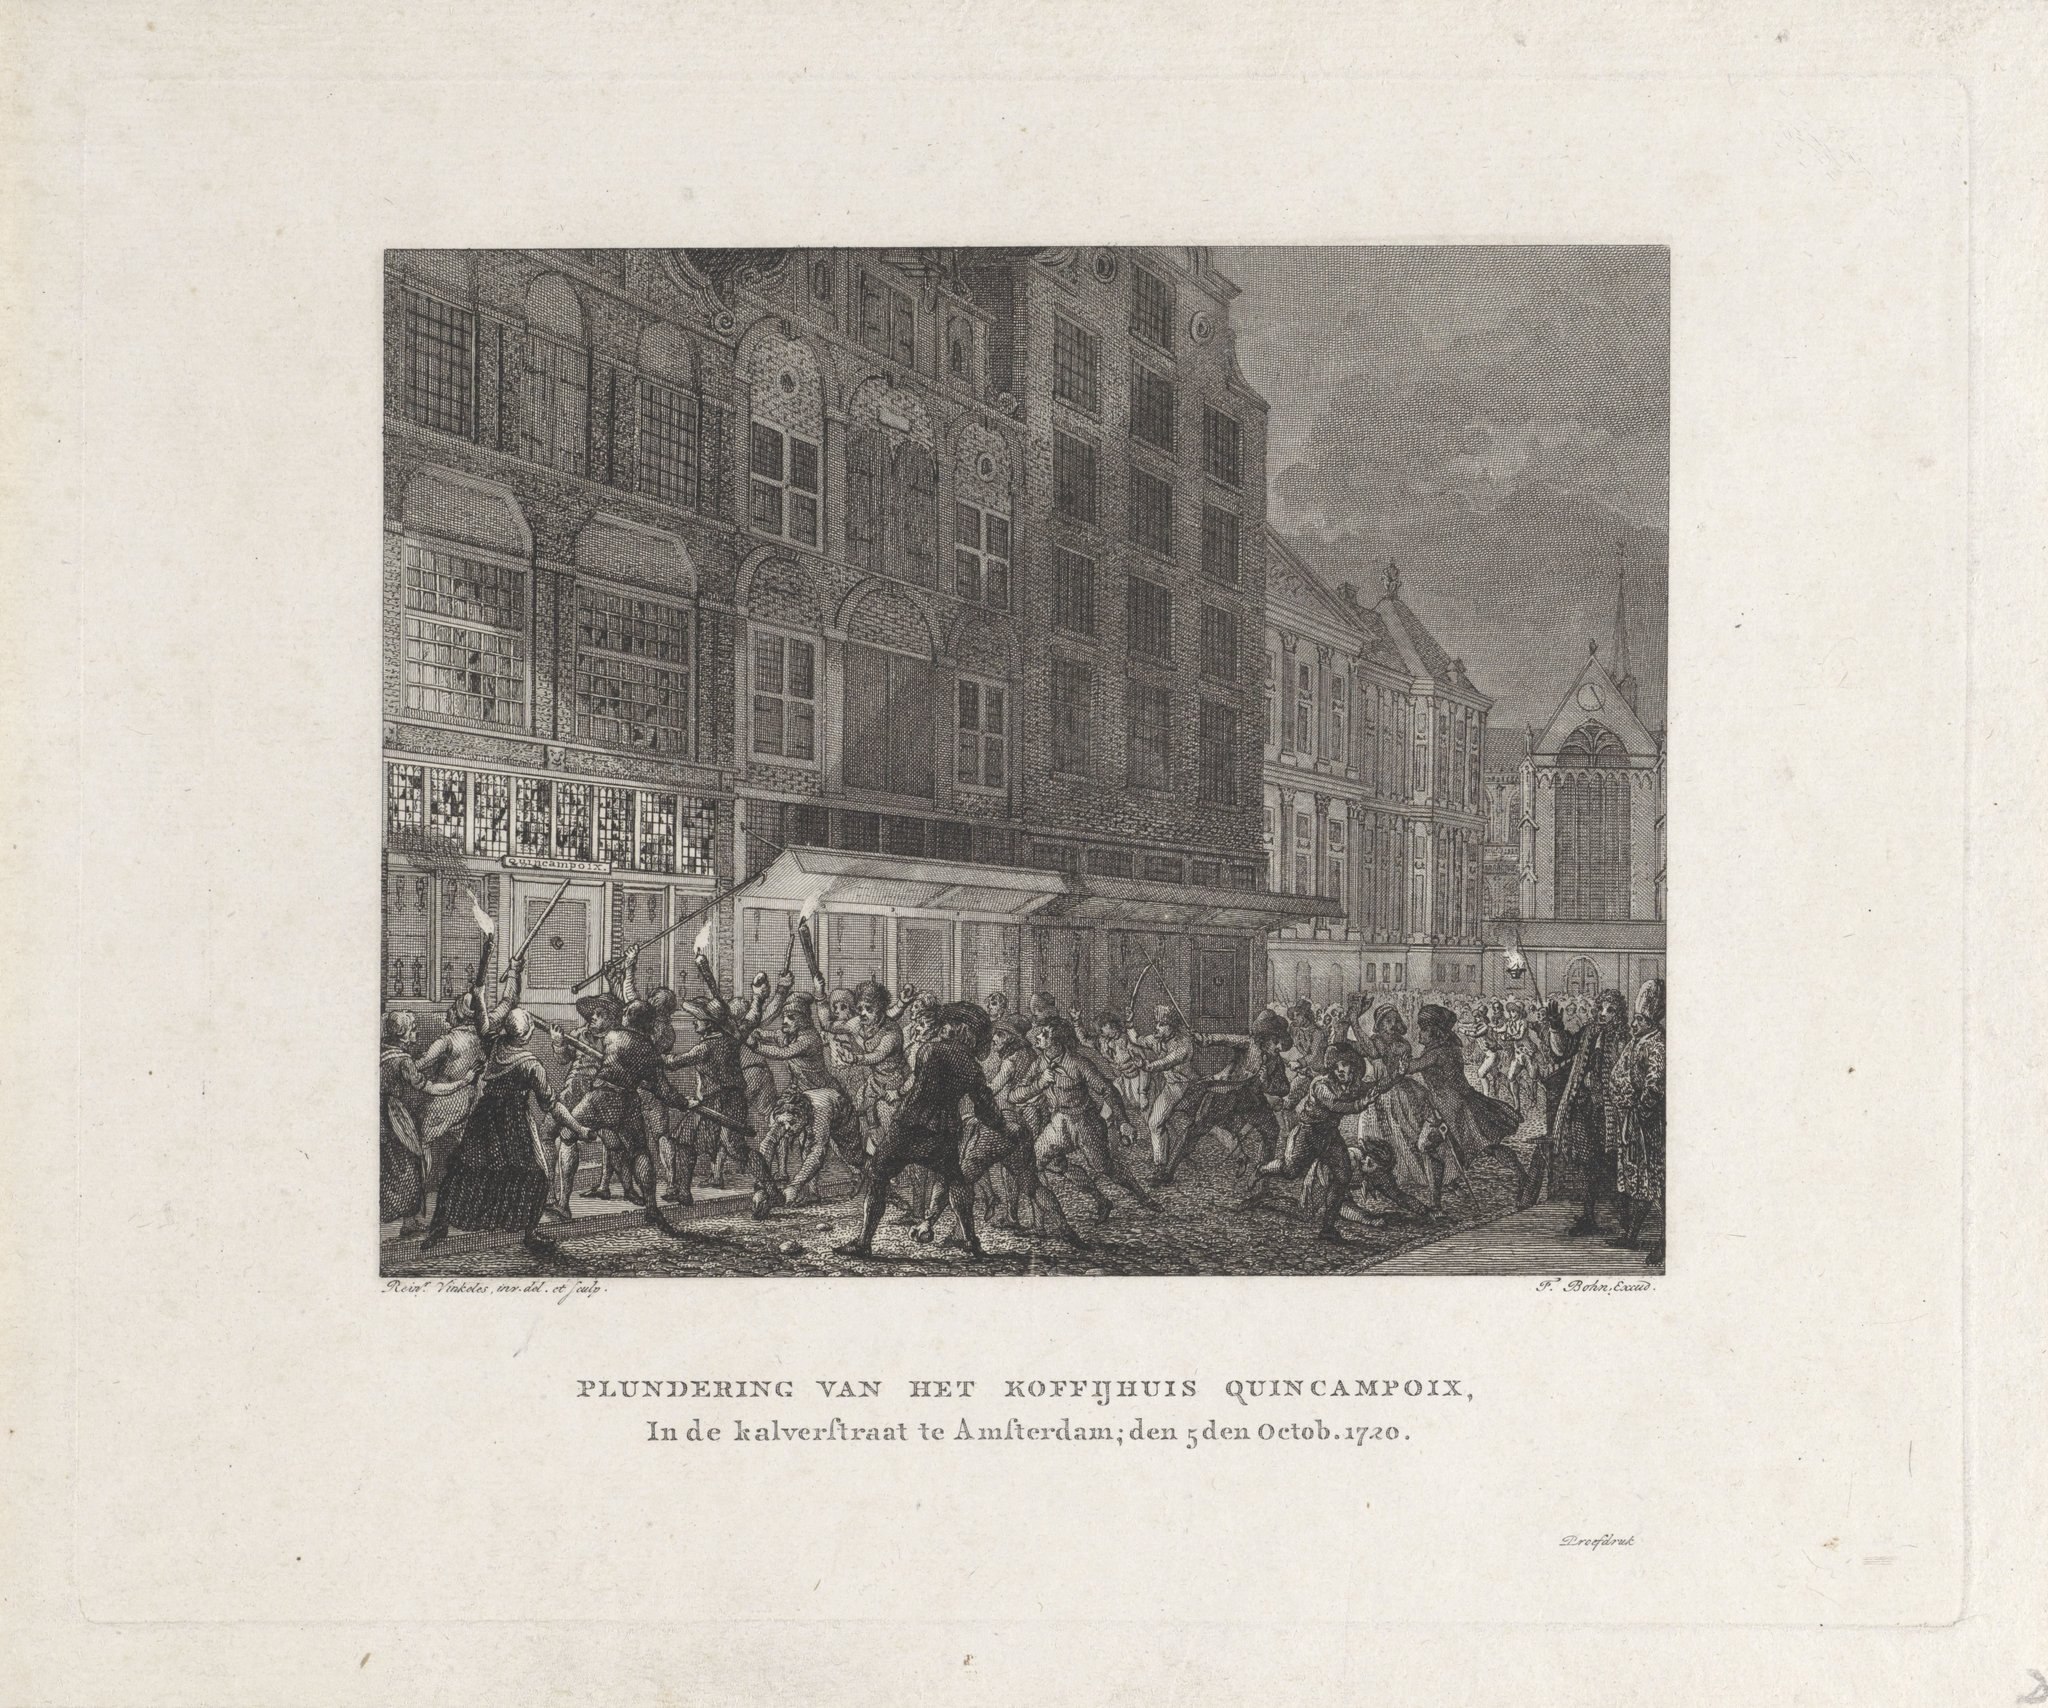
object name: print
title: Plundering van het koffiehuis Quincampoix, 1720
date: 1751-1812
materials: paper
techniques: engraving, etching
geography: amsterdam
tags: plundering ~ riot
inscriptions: collector's mark: Lugt 2228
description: Nachtelijke plundering door een oproerige menigte van het koffiehuis Quincampoix in de Kalverstraat te Amsterdam waar veel windhandel gedreven werd, 5 oktober 1720.